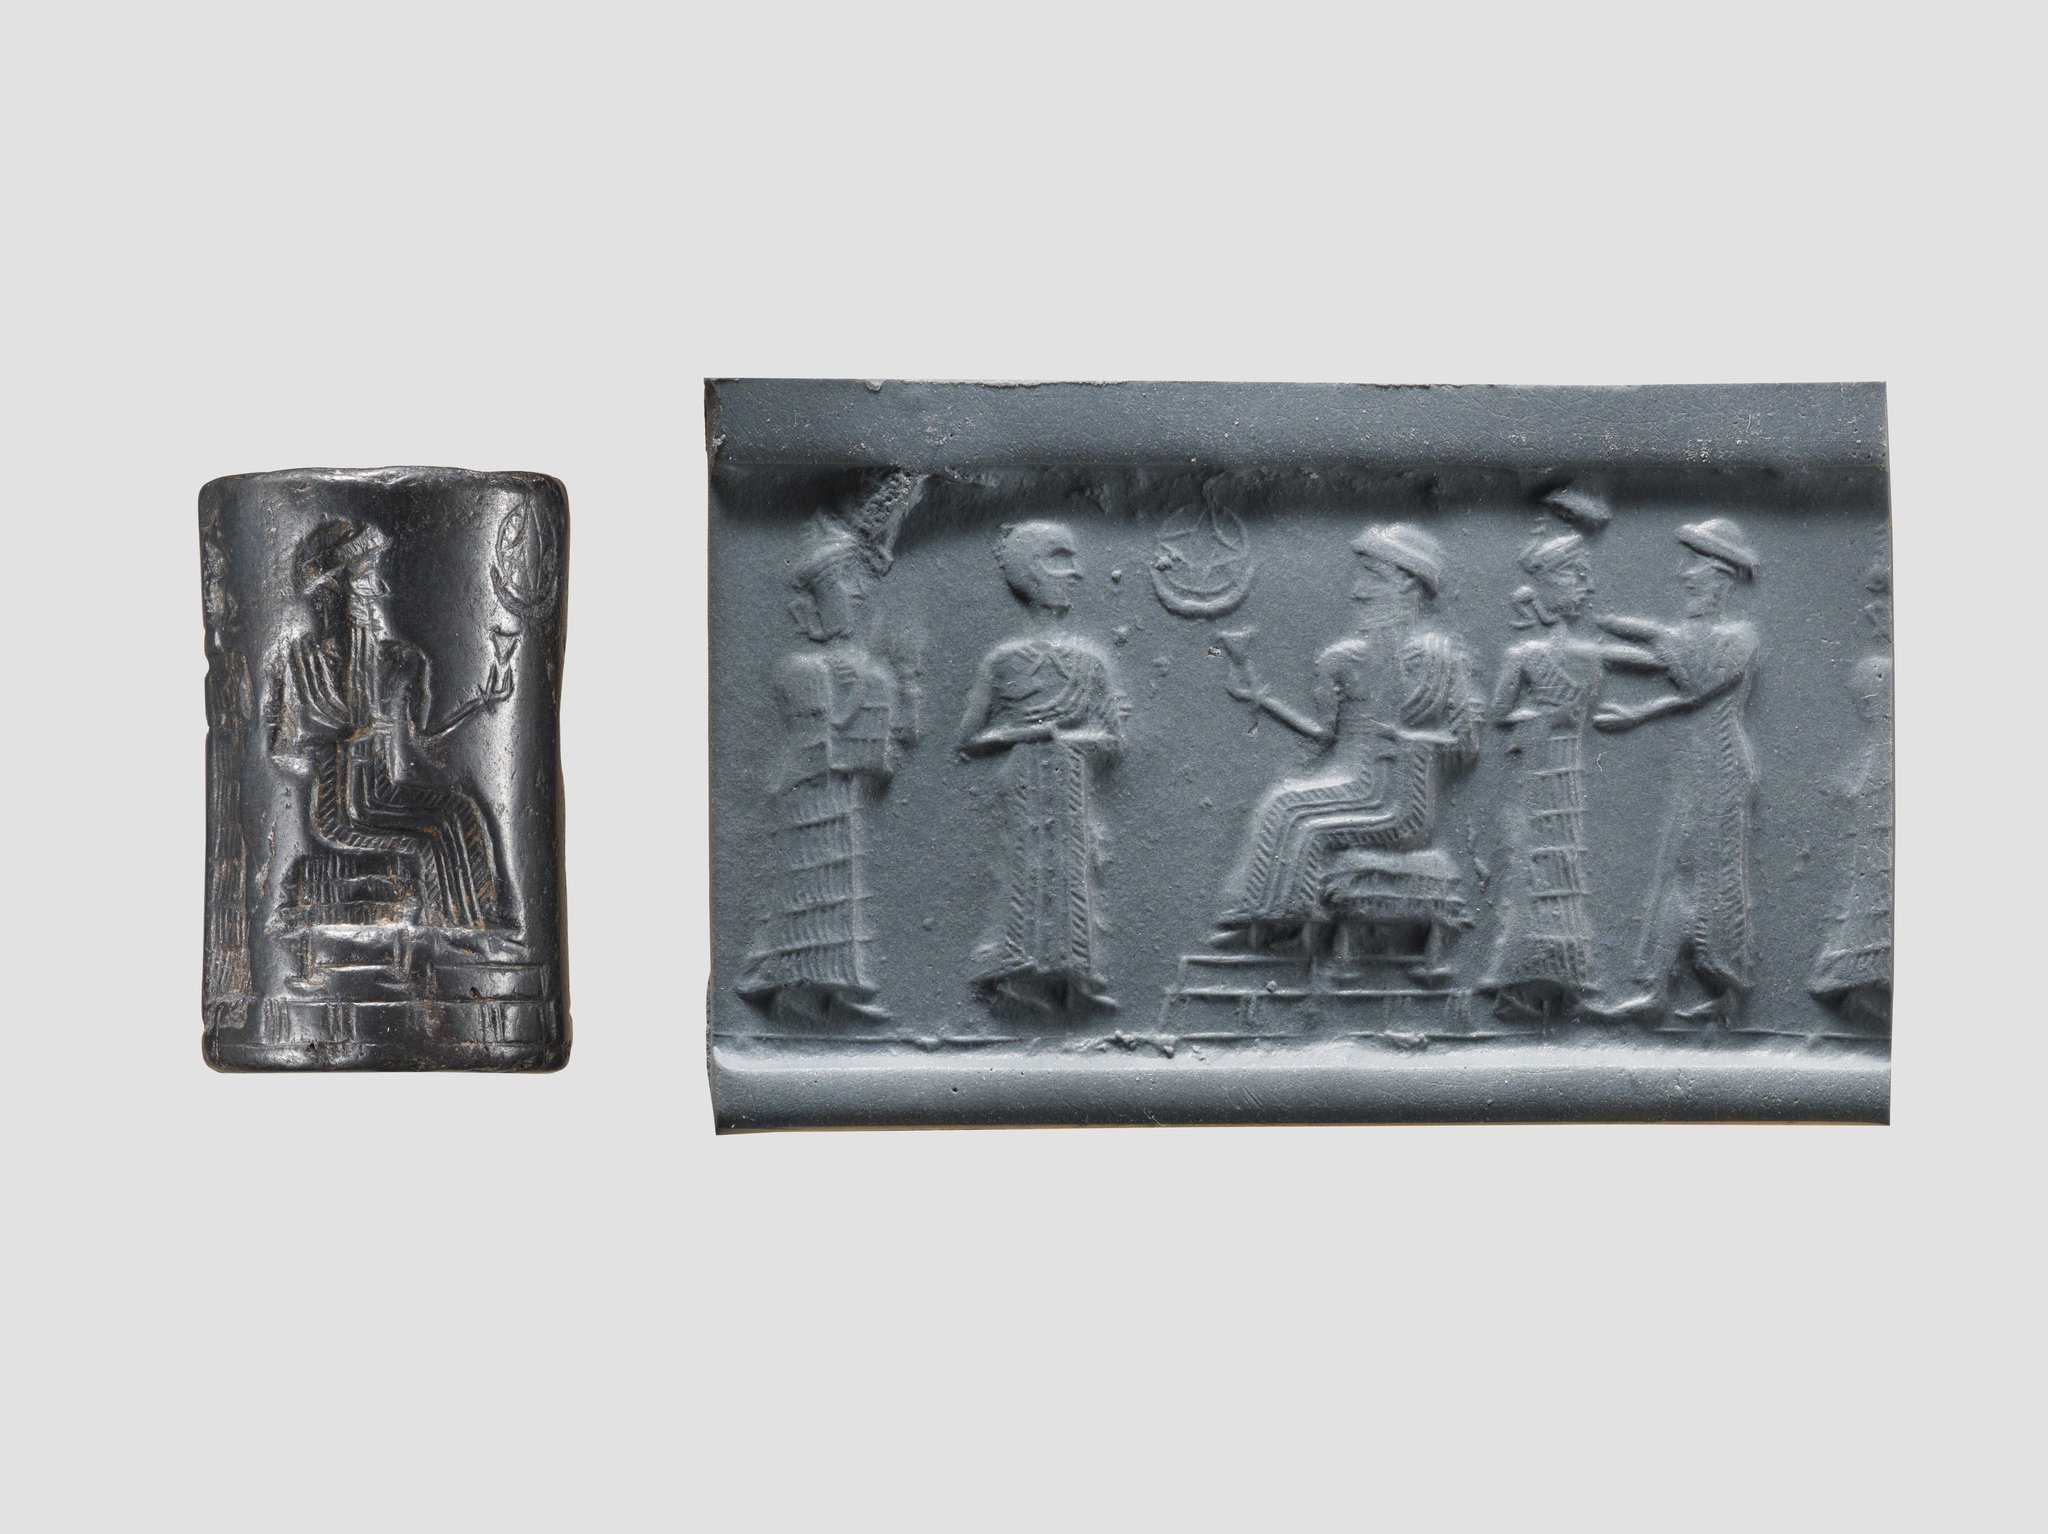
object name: cylinder seal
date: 2000-1668 BCE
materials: mineral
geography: mesopotamia